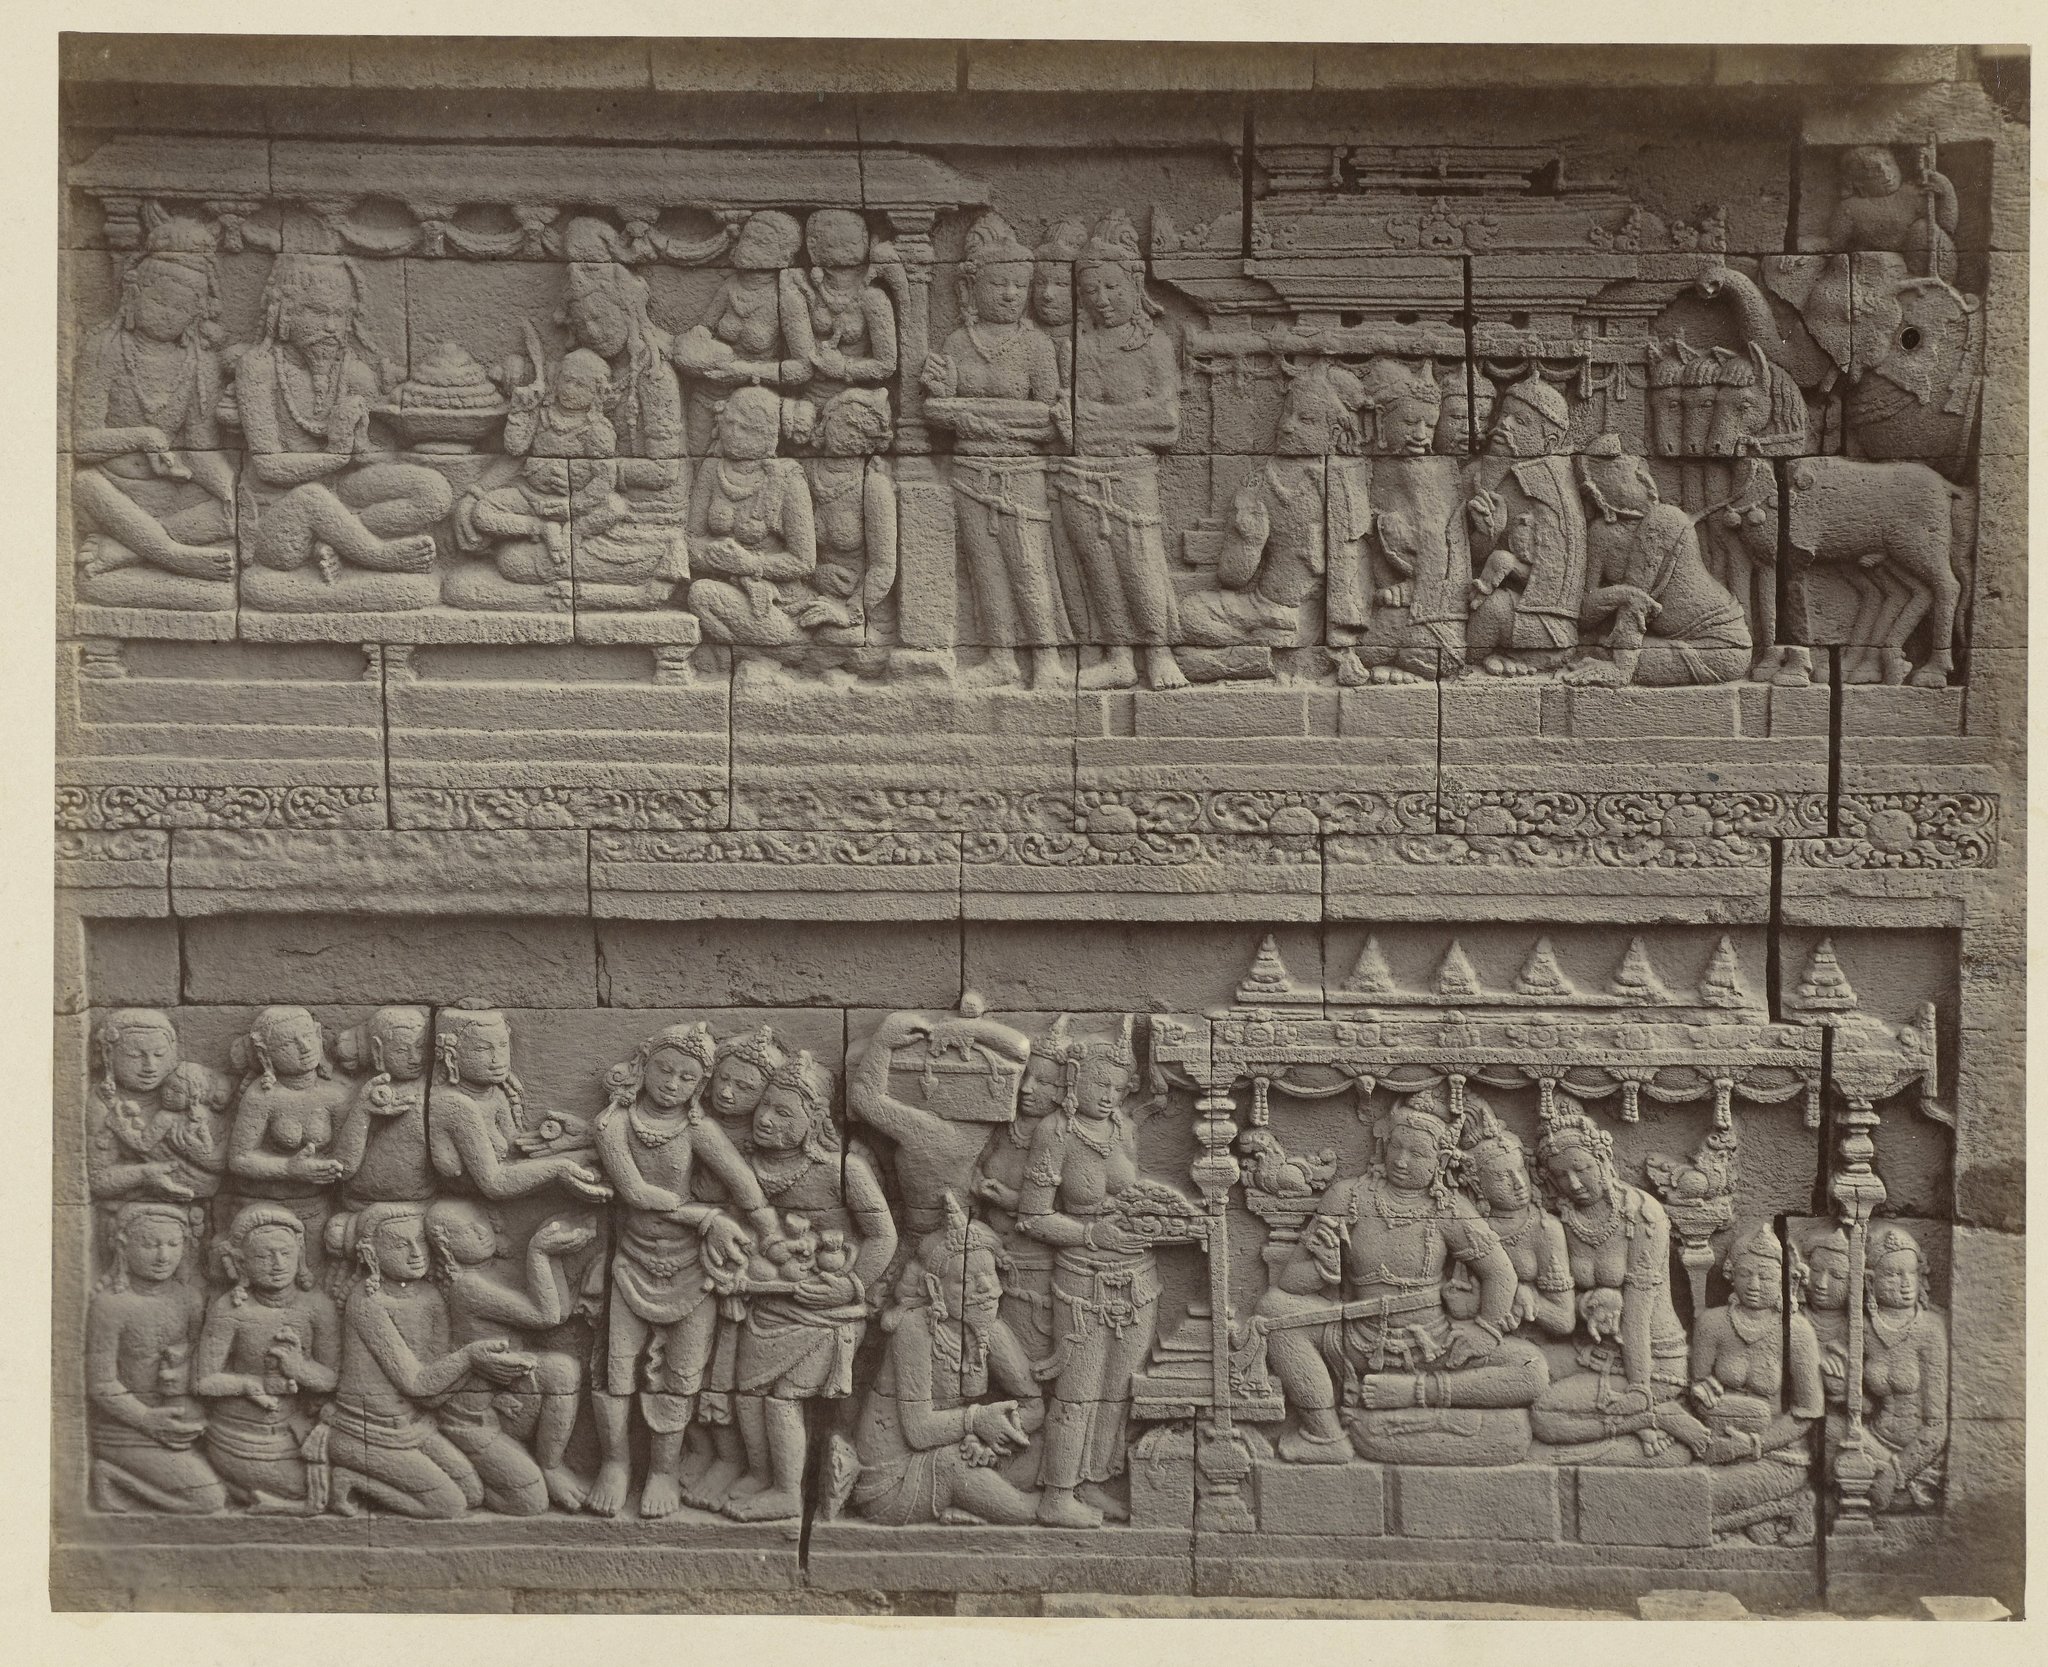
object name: photograph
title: Idem 2e gaanderij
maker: isidore kinsbergen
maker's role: fotograaf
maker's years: 1821-1905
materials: cardboard, paper, photographic support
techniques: albumen print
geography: java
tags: borobudur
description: Gallery I, main wall, south side 27 (top): Relief 1a-31, Lalitavistara relief, the seer Asita and his nephew visit Siddhartha, whi is sitting on his father's lap.. 28 (bottom): relief 1b-31, Avadana relief, Mandhatar story, King Uposadha showing charity. Borobudur village, Magelang district, Central Java province, 778-824 AD.